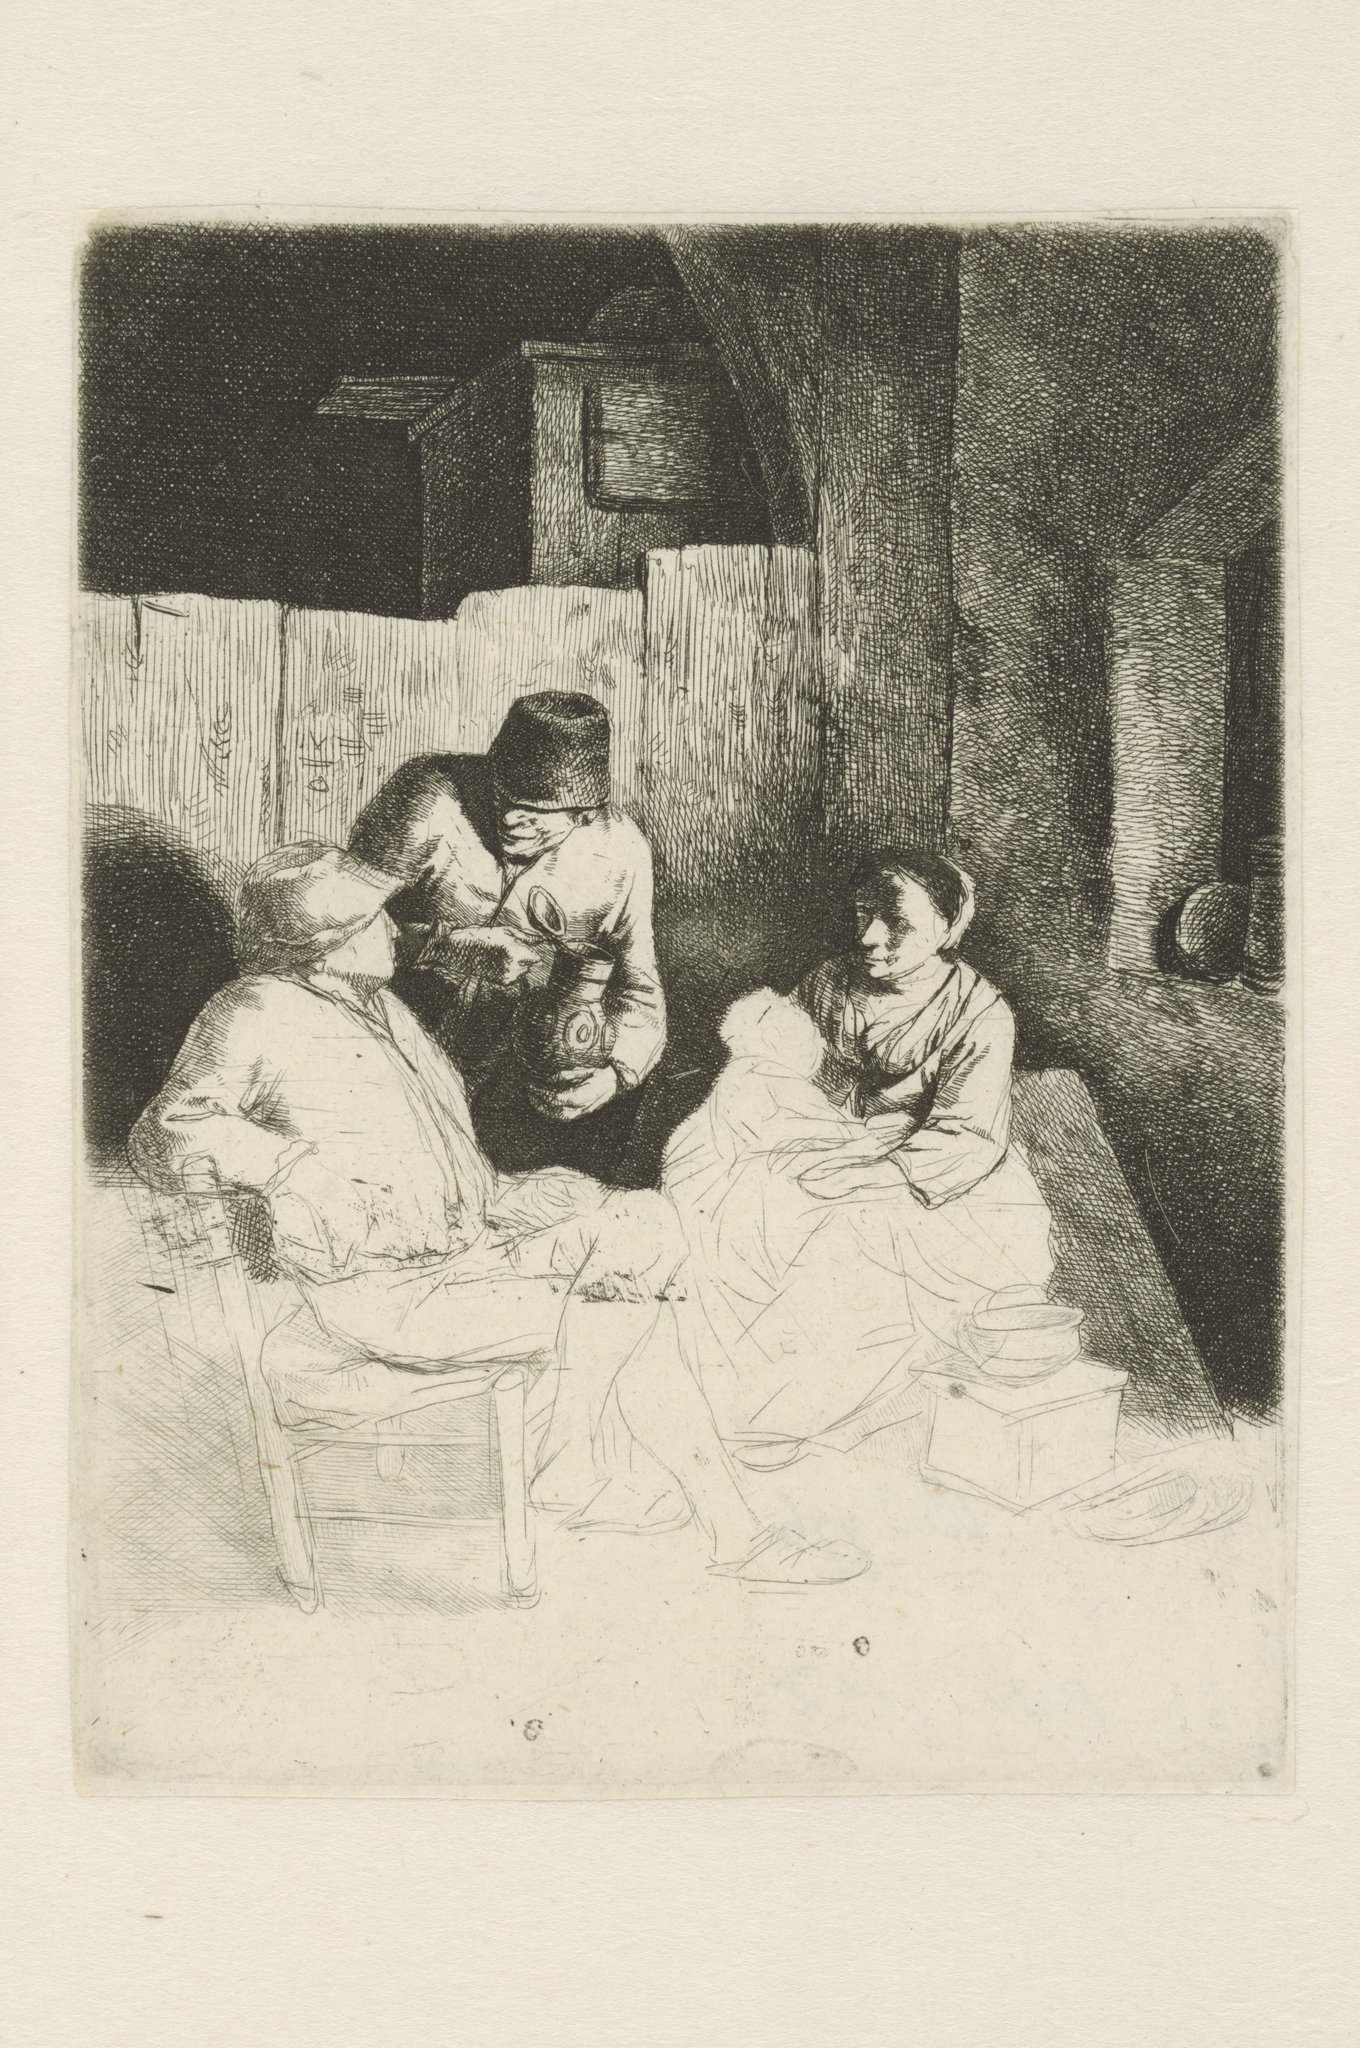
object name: print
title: Twee mannen en vrouw met kind zittend in herberg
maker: cornelis pietersz. bega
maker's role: draughtsman, painter, print maker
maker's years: 1631-1664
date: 1642-1664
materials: paper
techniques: etching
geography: netherlands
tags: mother and baby or young child